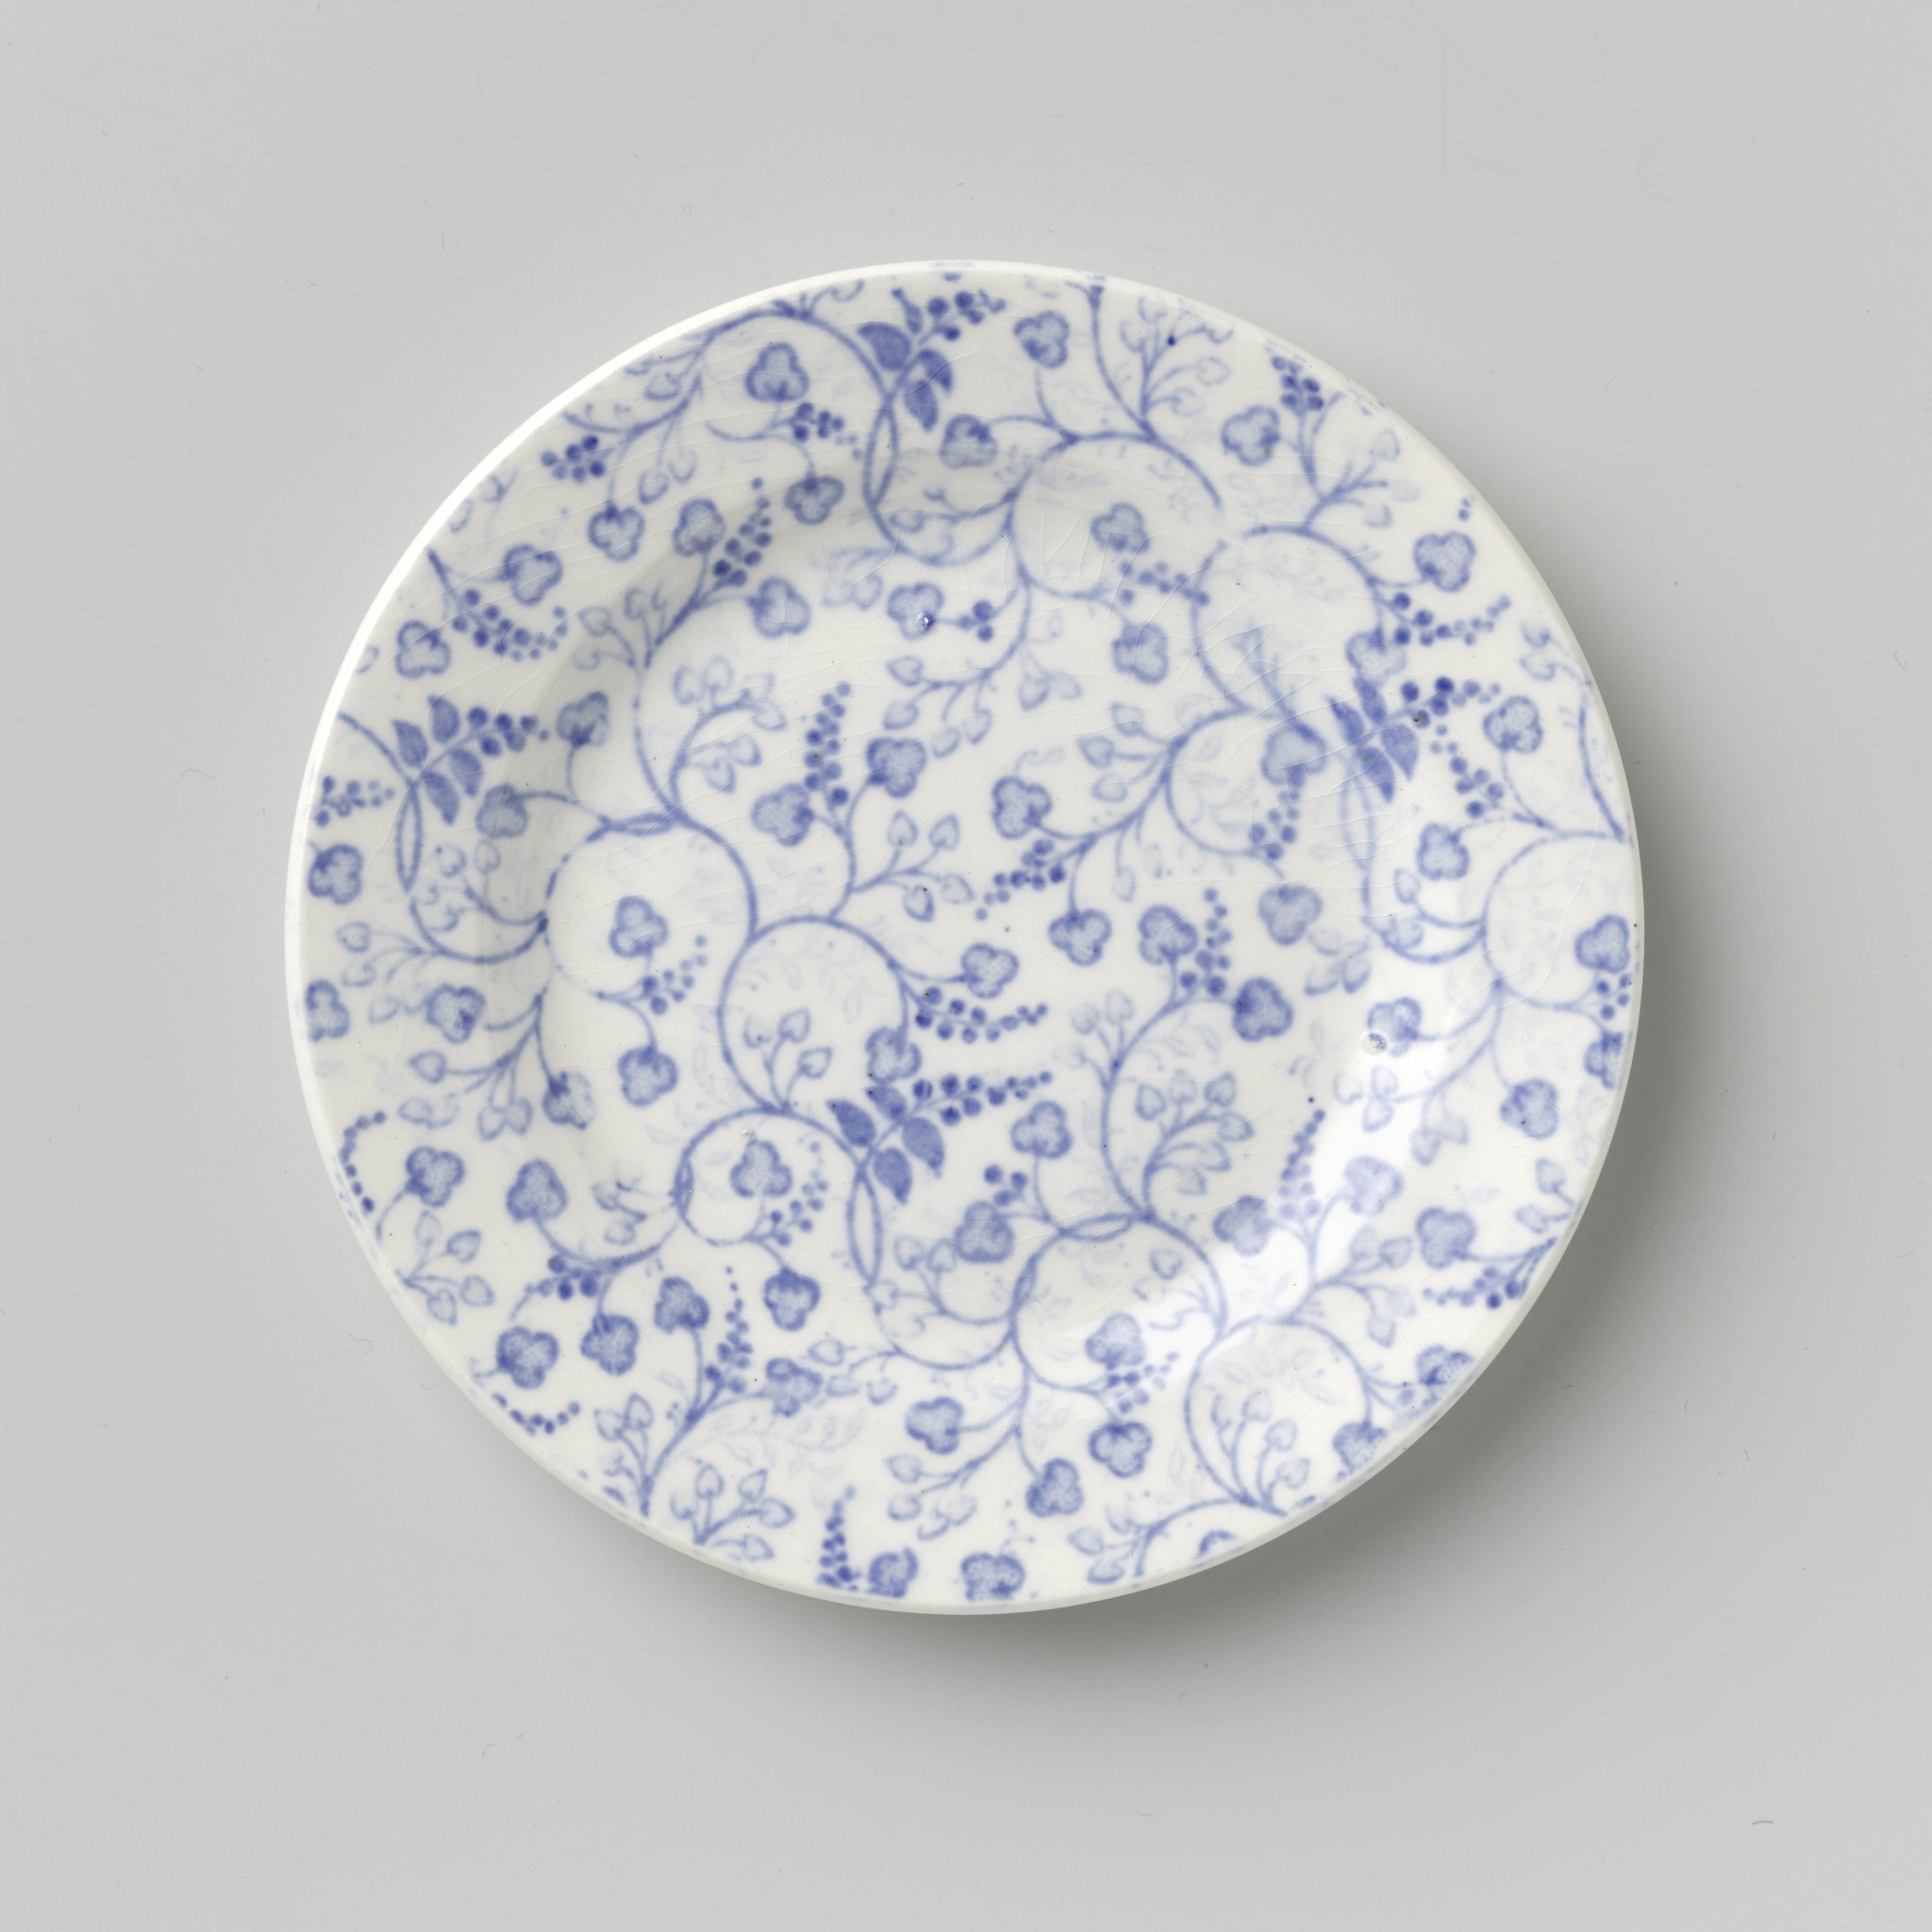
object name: plate dish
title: Bord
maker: petrus regout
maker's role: plateelbakker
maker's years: 1801-1879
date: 1867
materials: creamware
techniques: transfer decoration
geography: maastricht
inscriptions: mark: ‘PARSEME No 3’, check stamp: ‘PR // 29’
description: Bord van aardewerk, met blauw doorlopend bloemendecor, behorend tot een kinderservies.